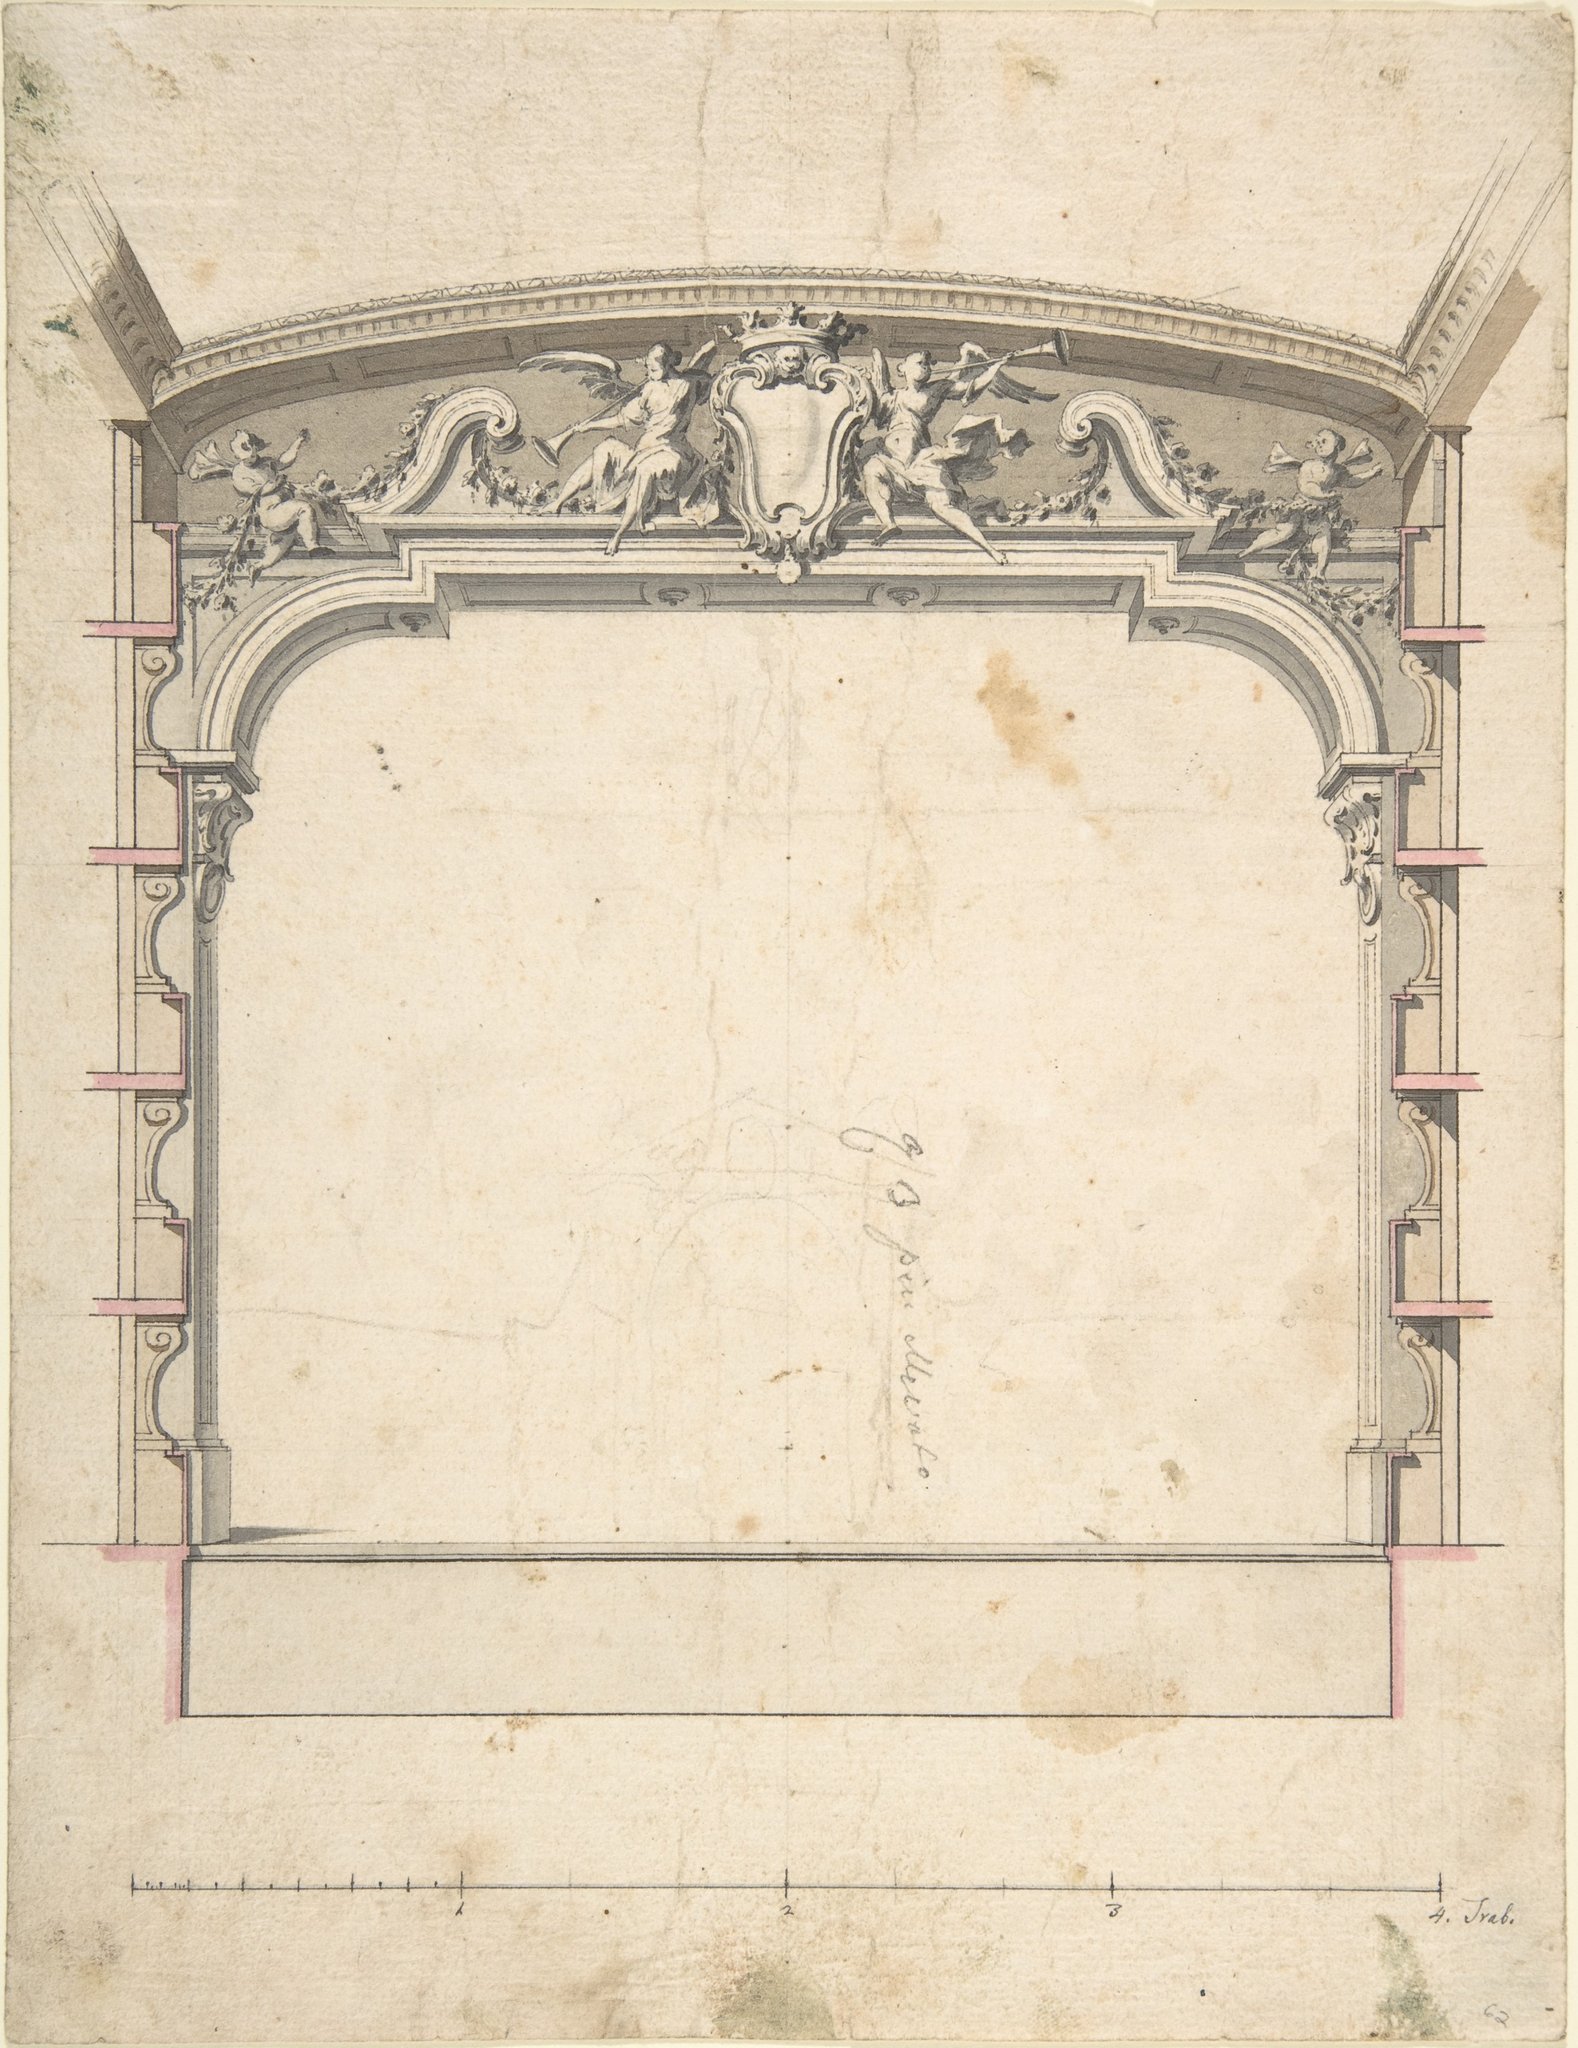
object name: drawing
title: Design for the Proscenium Arch of a Theatre with Two Trumpeting Angels Holding a Cartouche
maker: anonymous, italian, piedmontese, 18th century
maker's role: artist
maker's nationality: italian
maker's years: 1700-1800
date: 1700-1780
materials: graphite, ink, drawing material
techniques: brush, pen, wash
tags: theatre,architecture